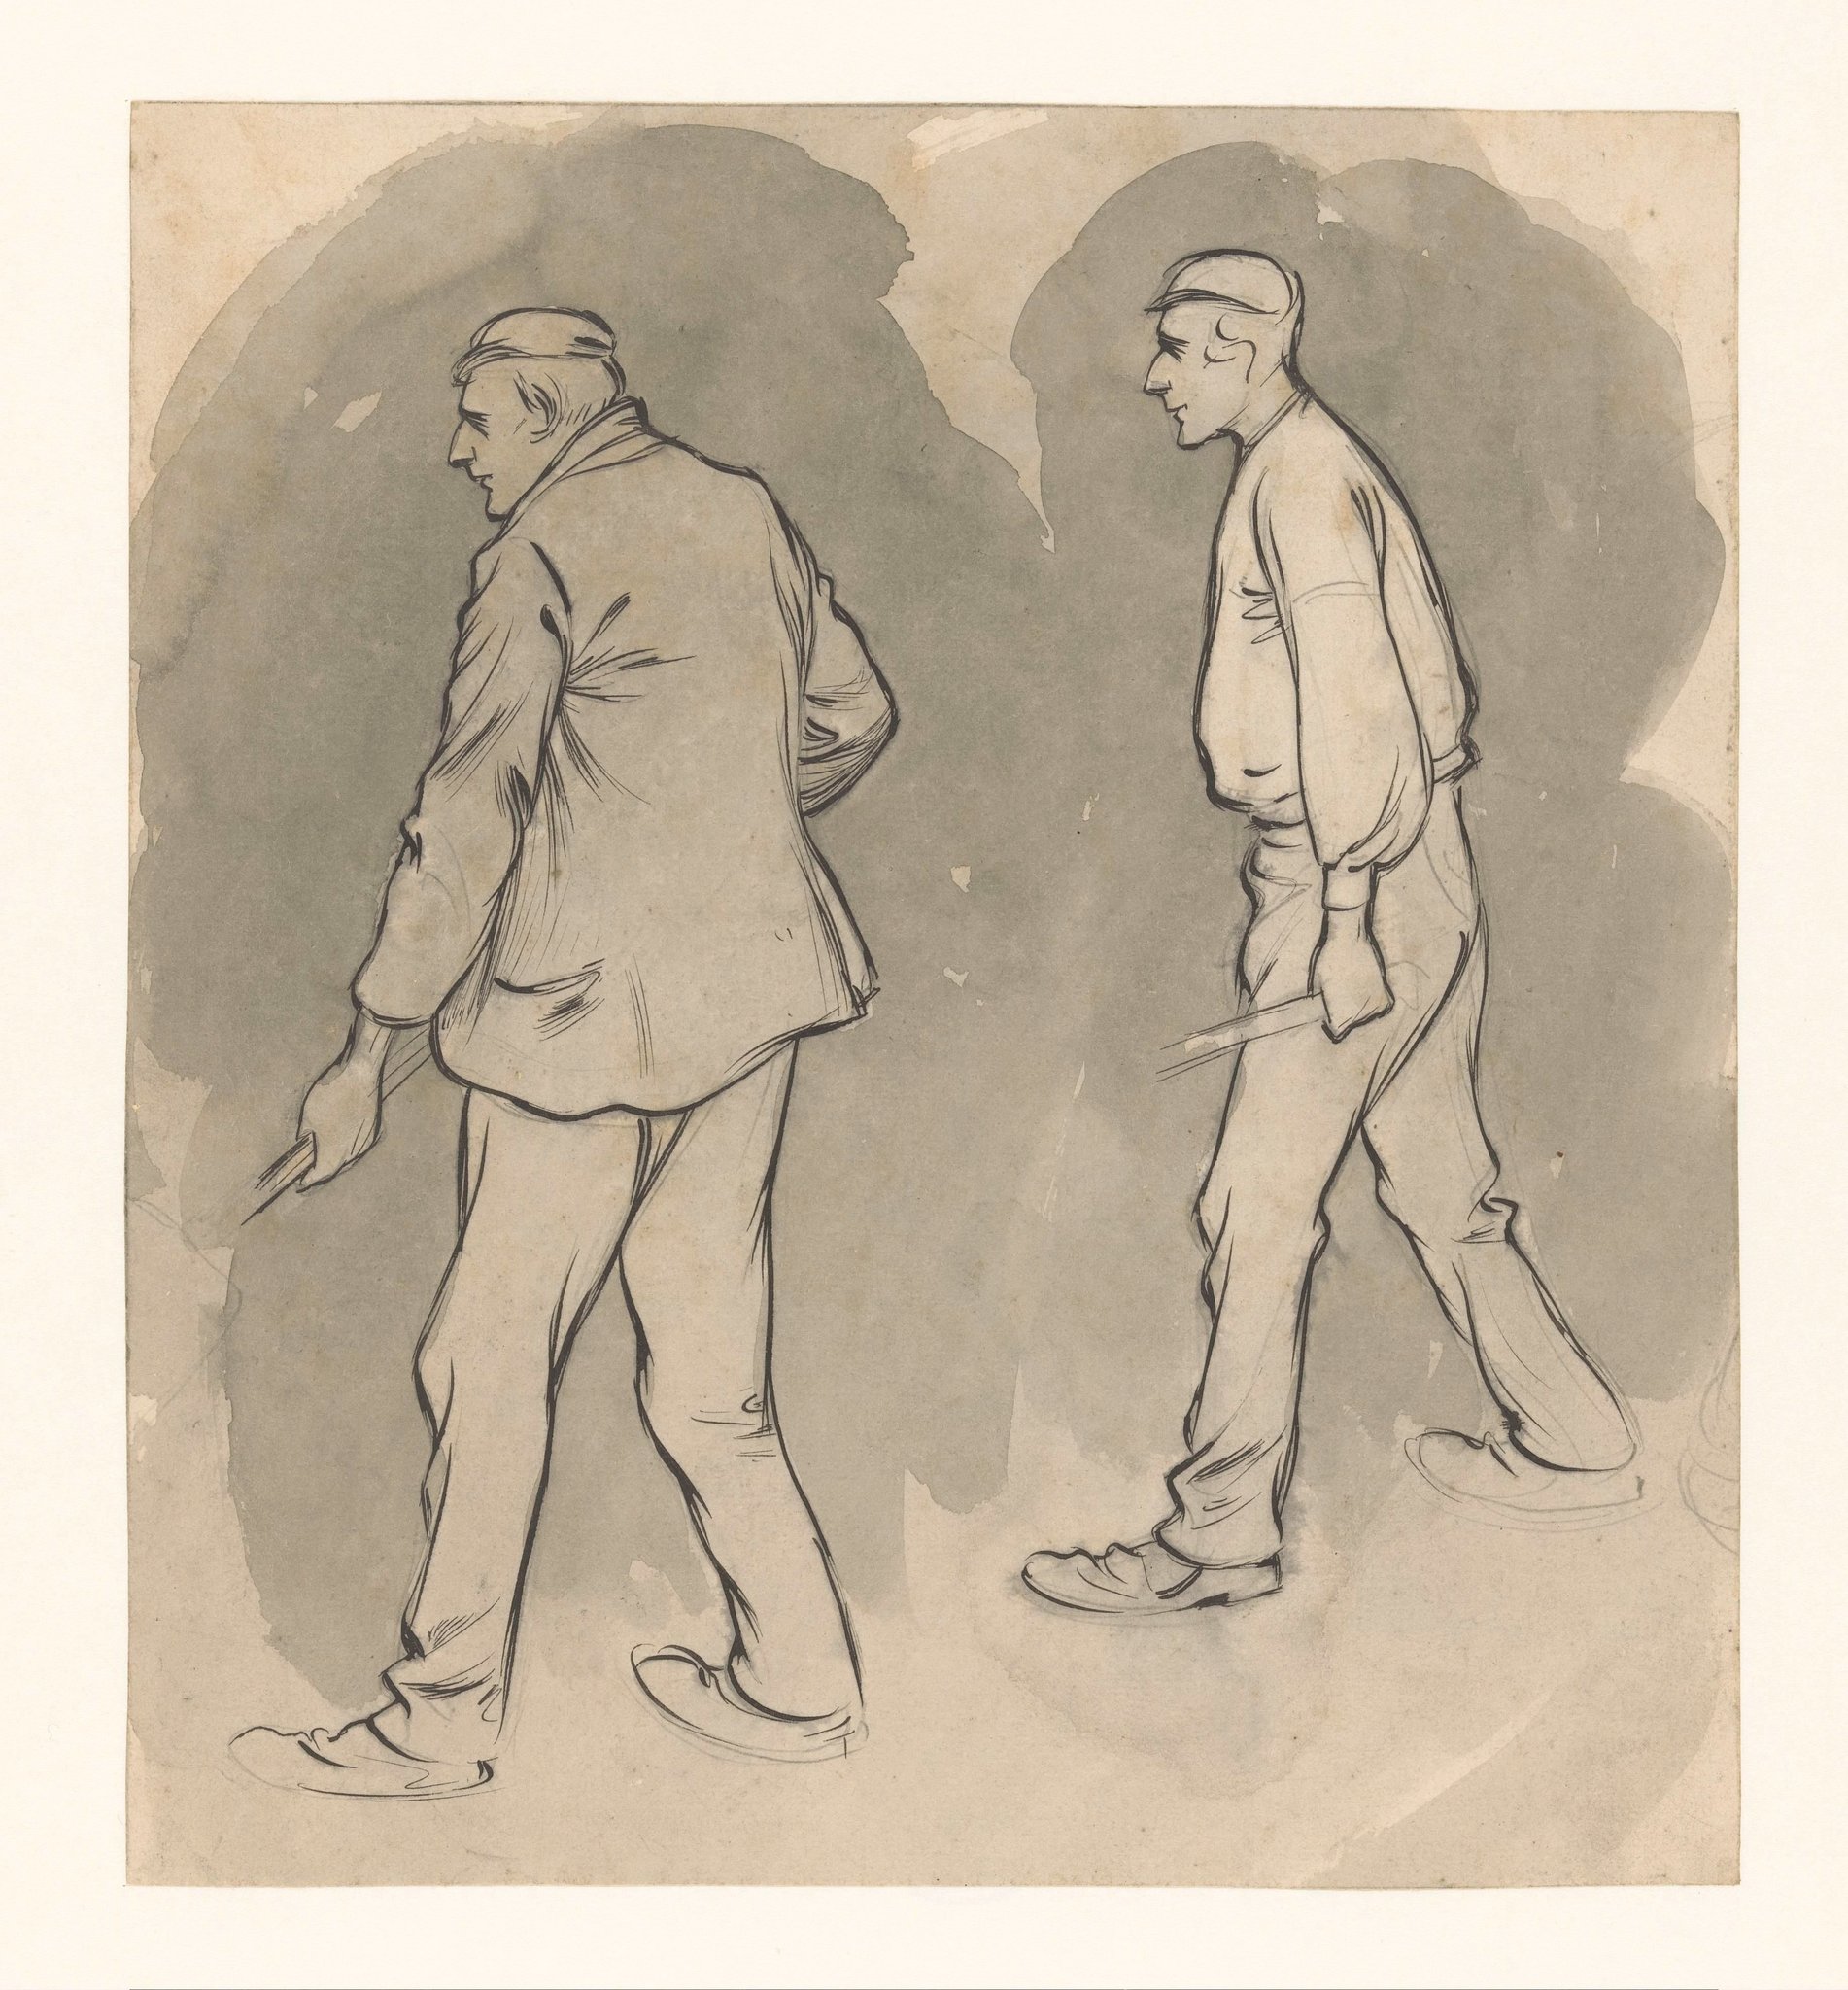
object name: drawing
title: Twee arbeiders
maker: jan de waardt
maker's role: draughtsman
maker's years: 1871-1909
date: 1875-1900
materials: ink, paper, pencil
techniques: brush, pen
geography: netherlands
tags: working class, labourers, netherlands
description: Twee staande mannen met pet en onbepaalde instrumenten in hun handen. De linker heeft waarschijnlijk een schop in de handen. De rechterman is licht voorovergebogen alsof hij een kruiwagen duwt. keerzijde: Aanzet in potlood van een straatzicht.